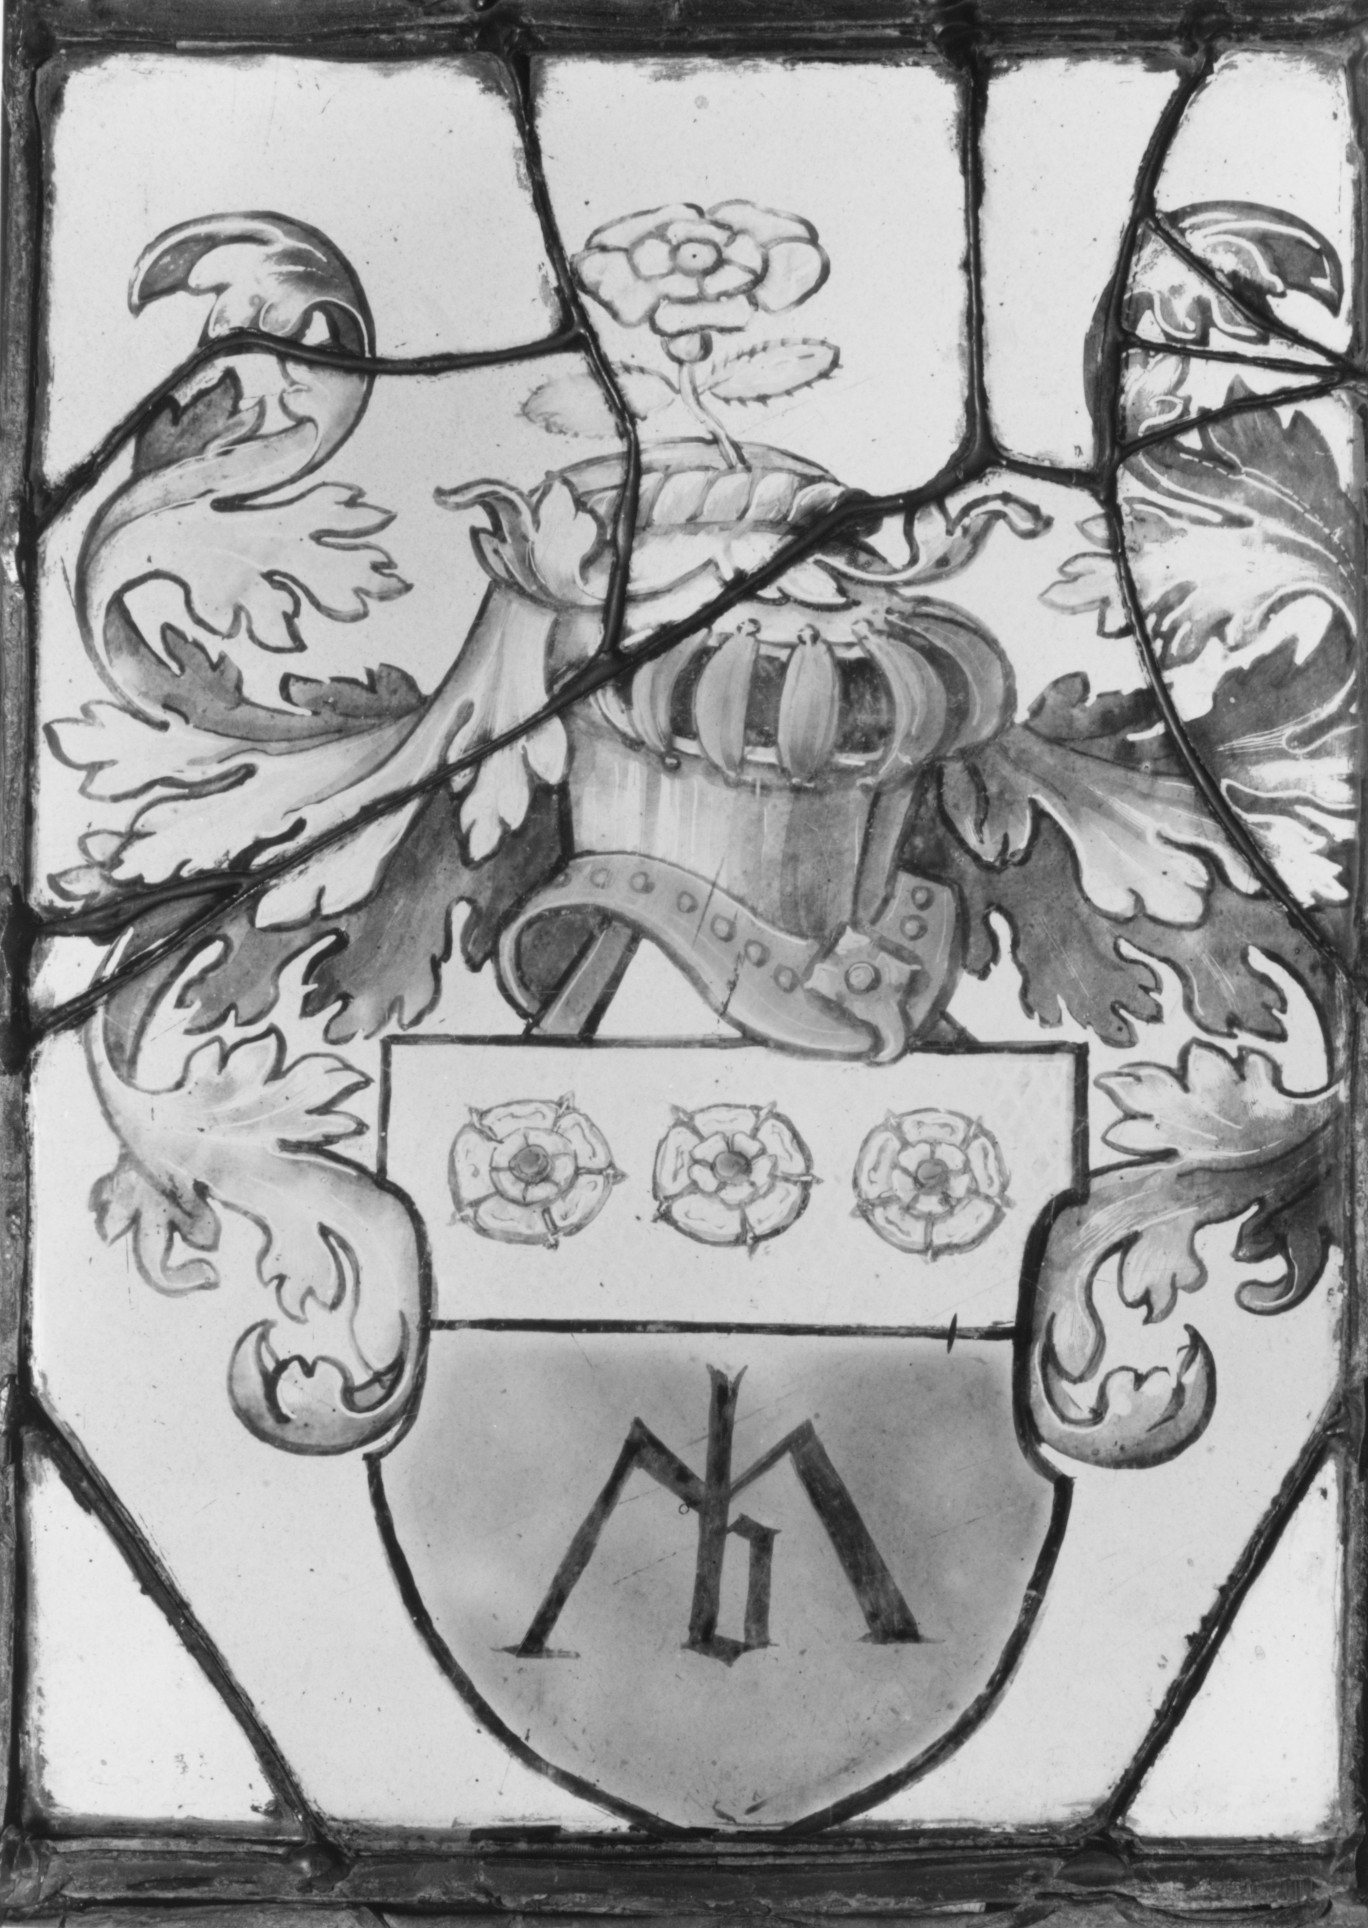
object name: heraldic panel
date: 1501-1600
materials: glass